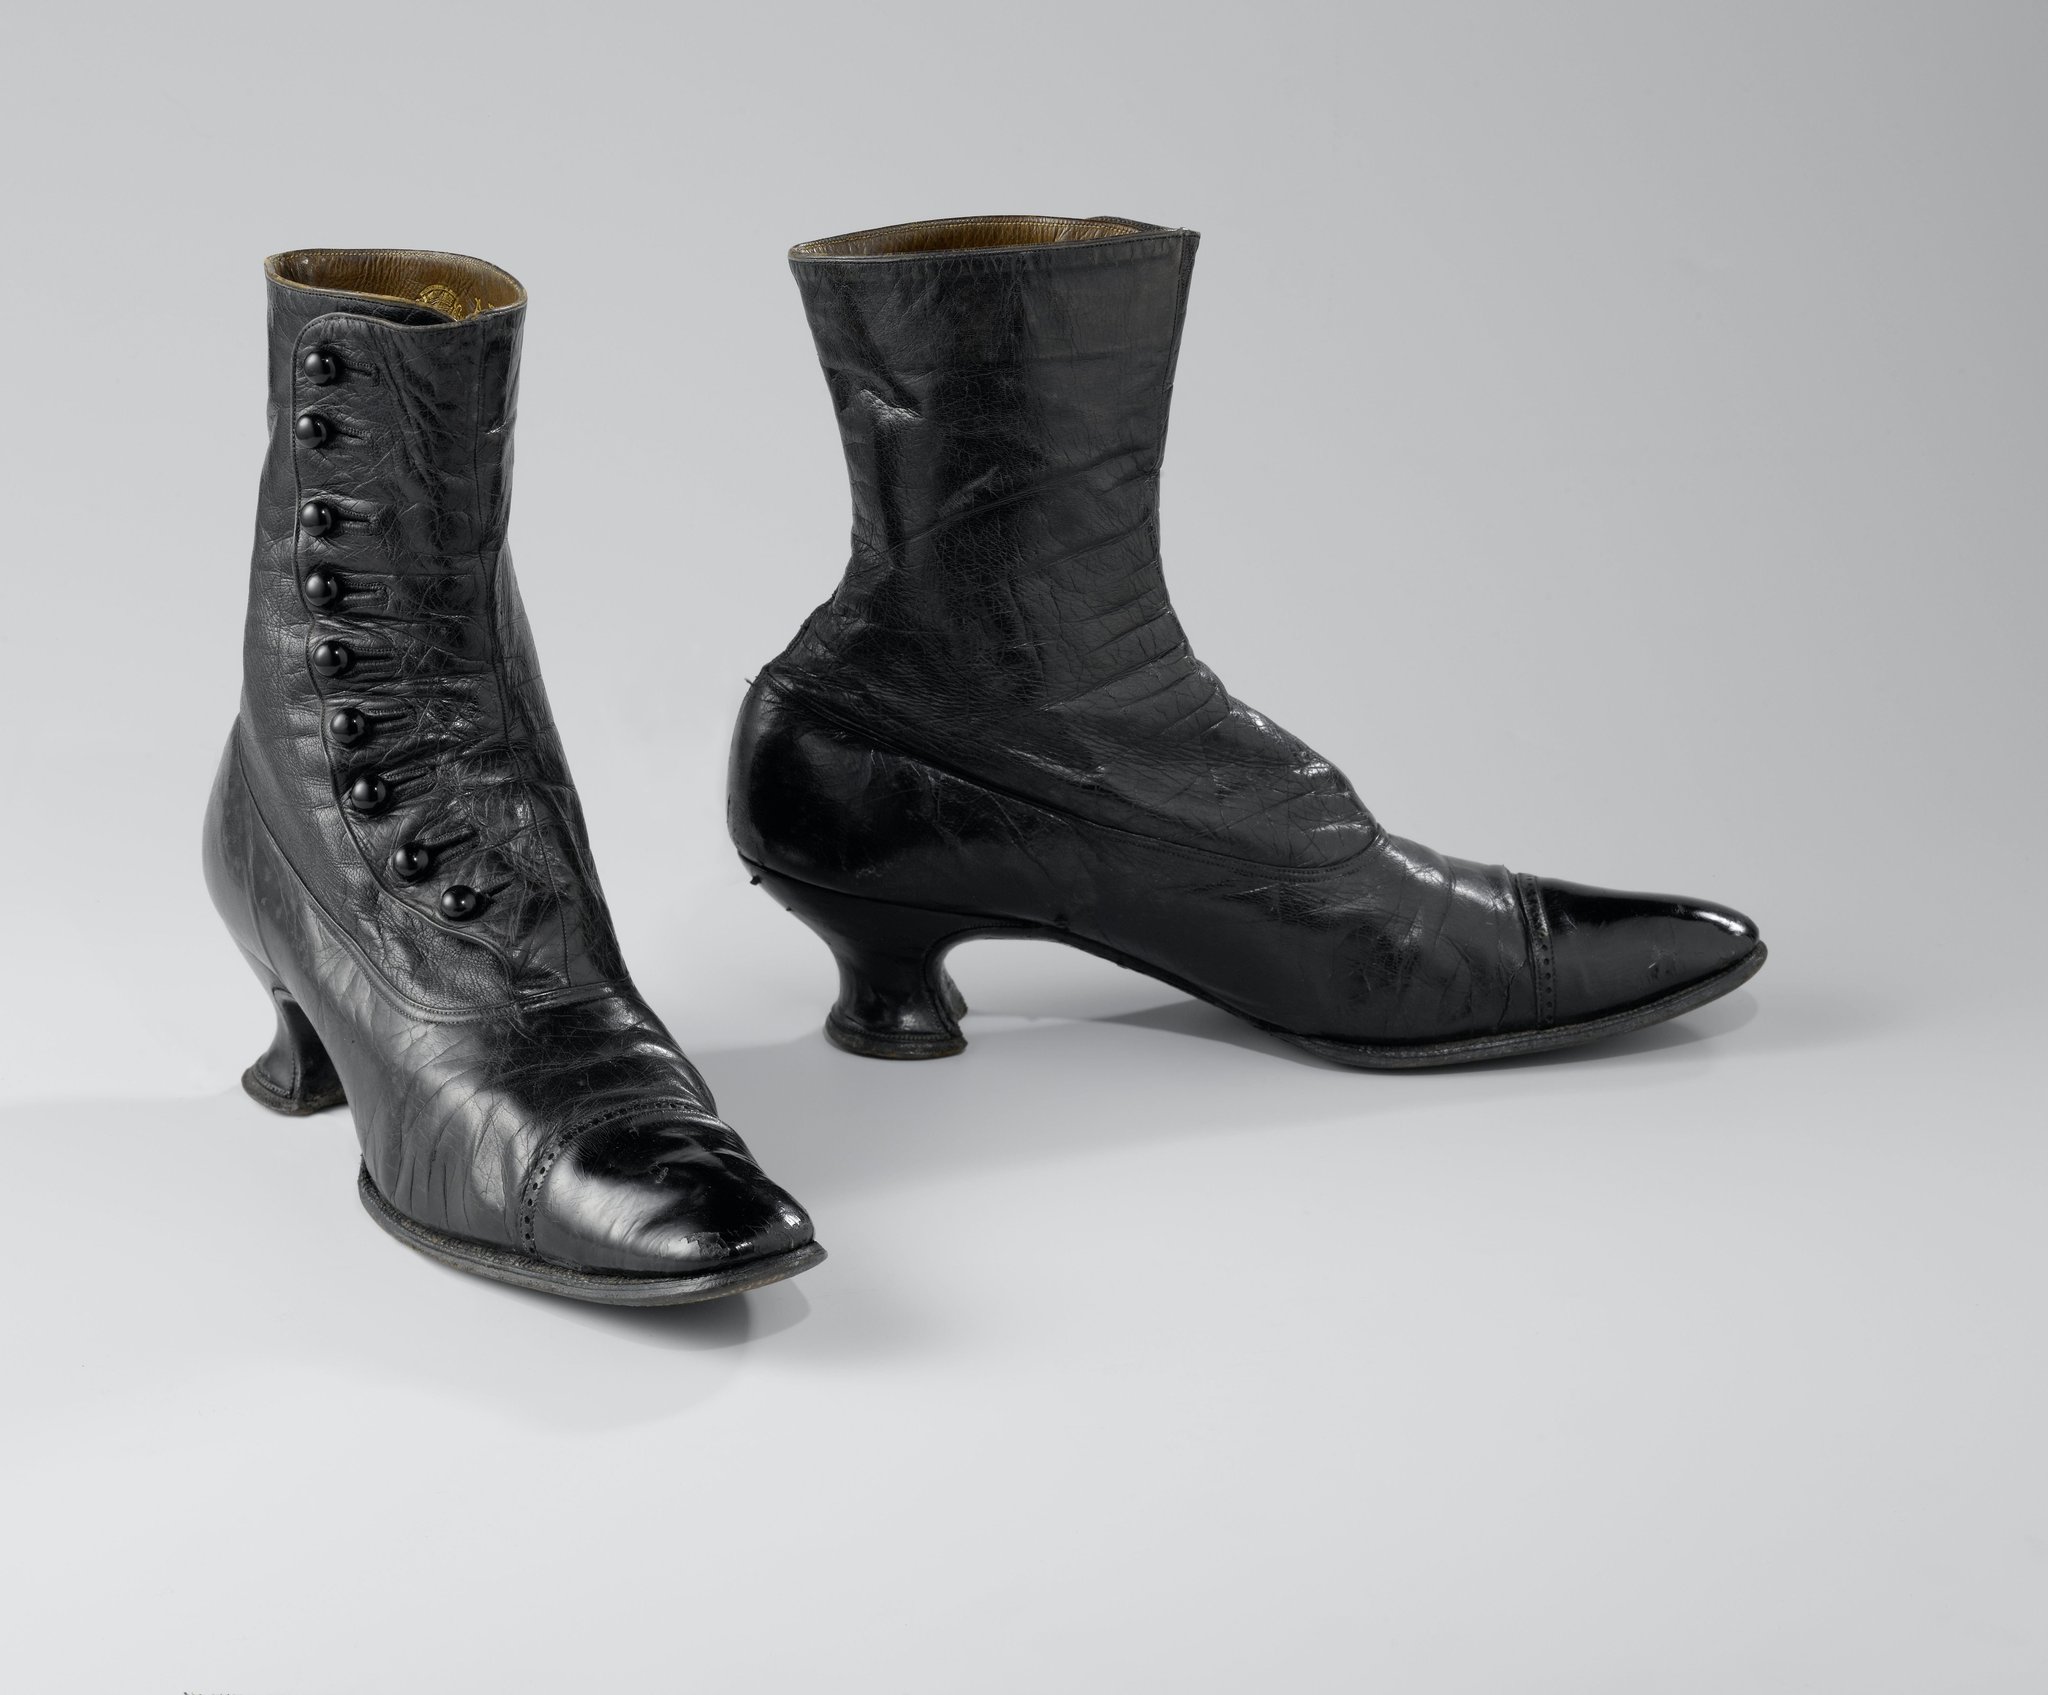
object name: knooplaars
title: Pair of buttoned boots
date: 1895-1910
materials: leather, linen, plastic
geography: paris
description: Linker knooplaarsje van zwart glacéleer en lak. Model: half hoog met leer bekleede pompadour hak en leren zool. Gevoerd met linnen.